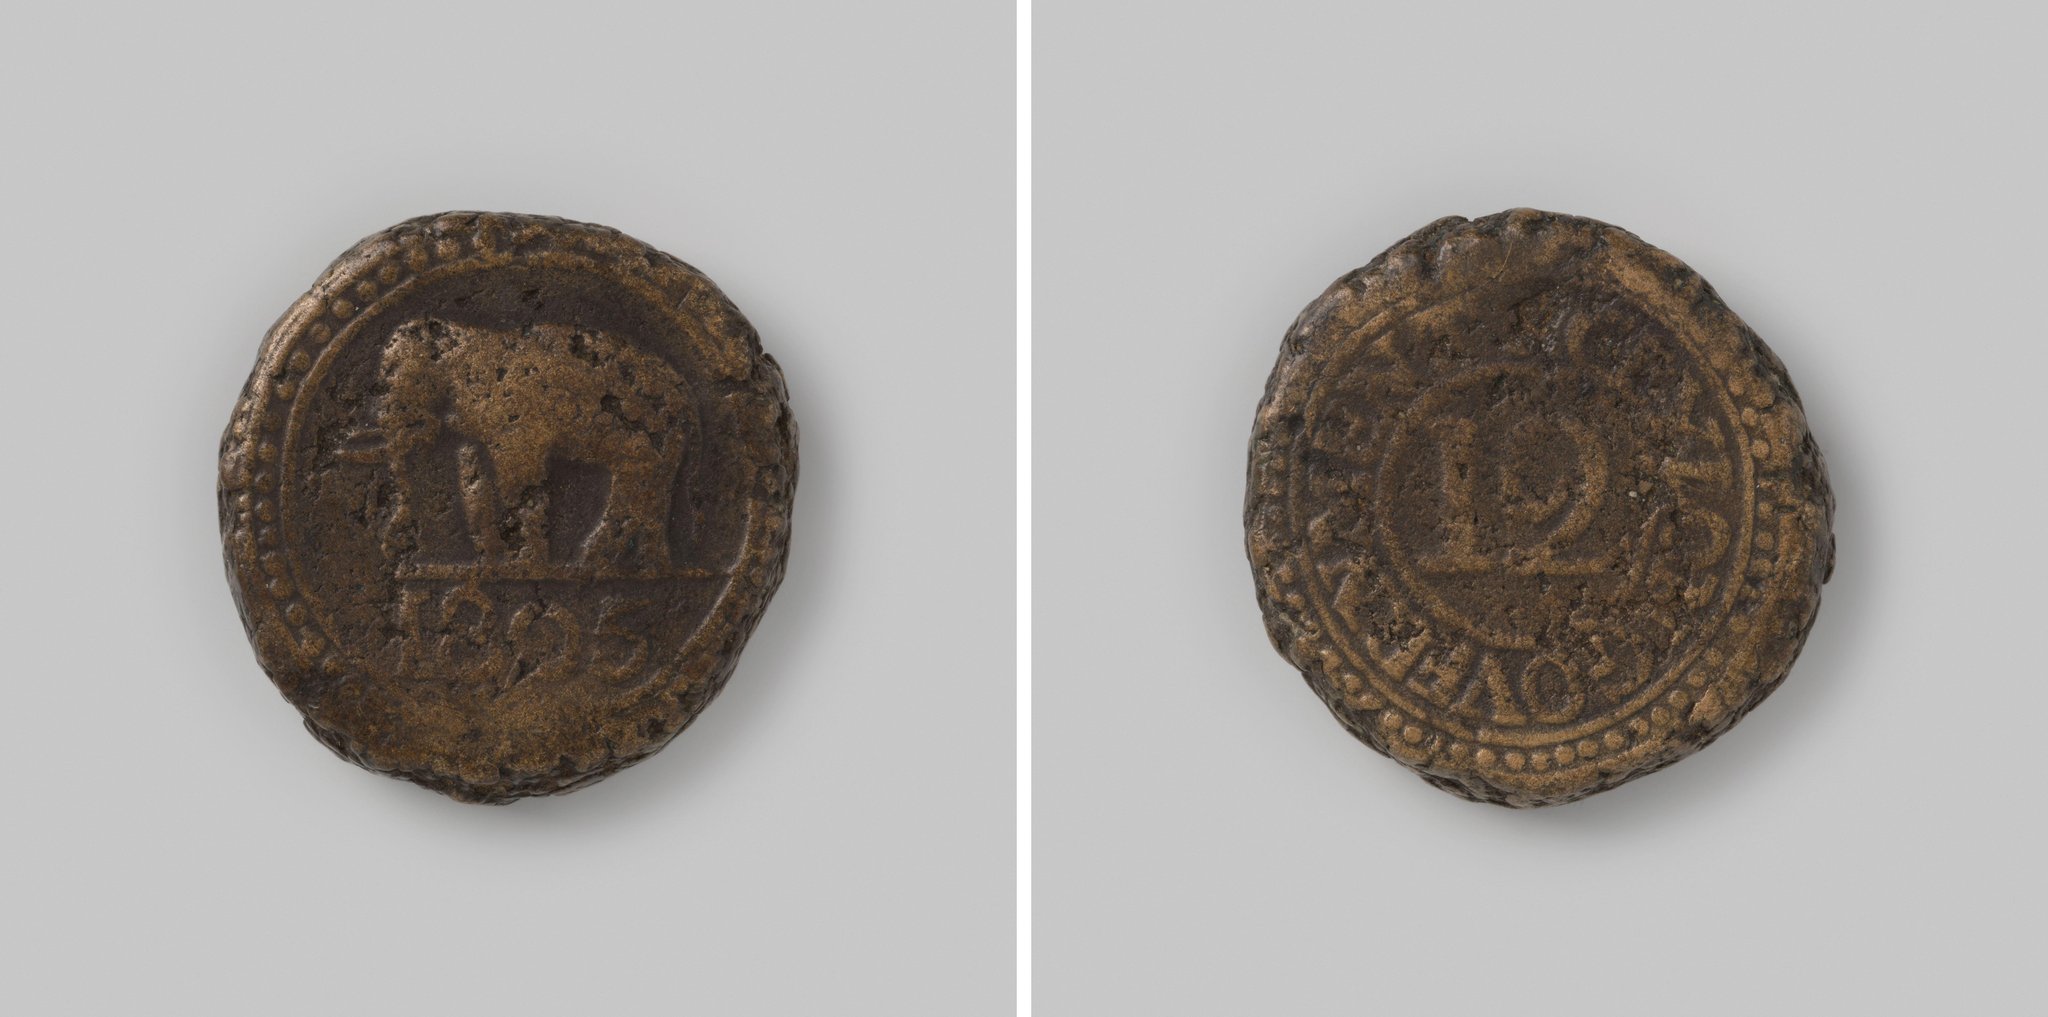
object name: coin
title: Sri Lanka, Ceylon, 4 stivers, 1805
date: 1805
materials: copper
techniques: striking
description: Koperen munt. Voorzijde: lopende olifant naar links. In afsnede jaartal onderaan. Keerzijde: binnen cirkel van stippen waarde-aanduiding: 12 [=1/12 rixdollar]. Geslagen in Ceylon.